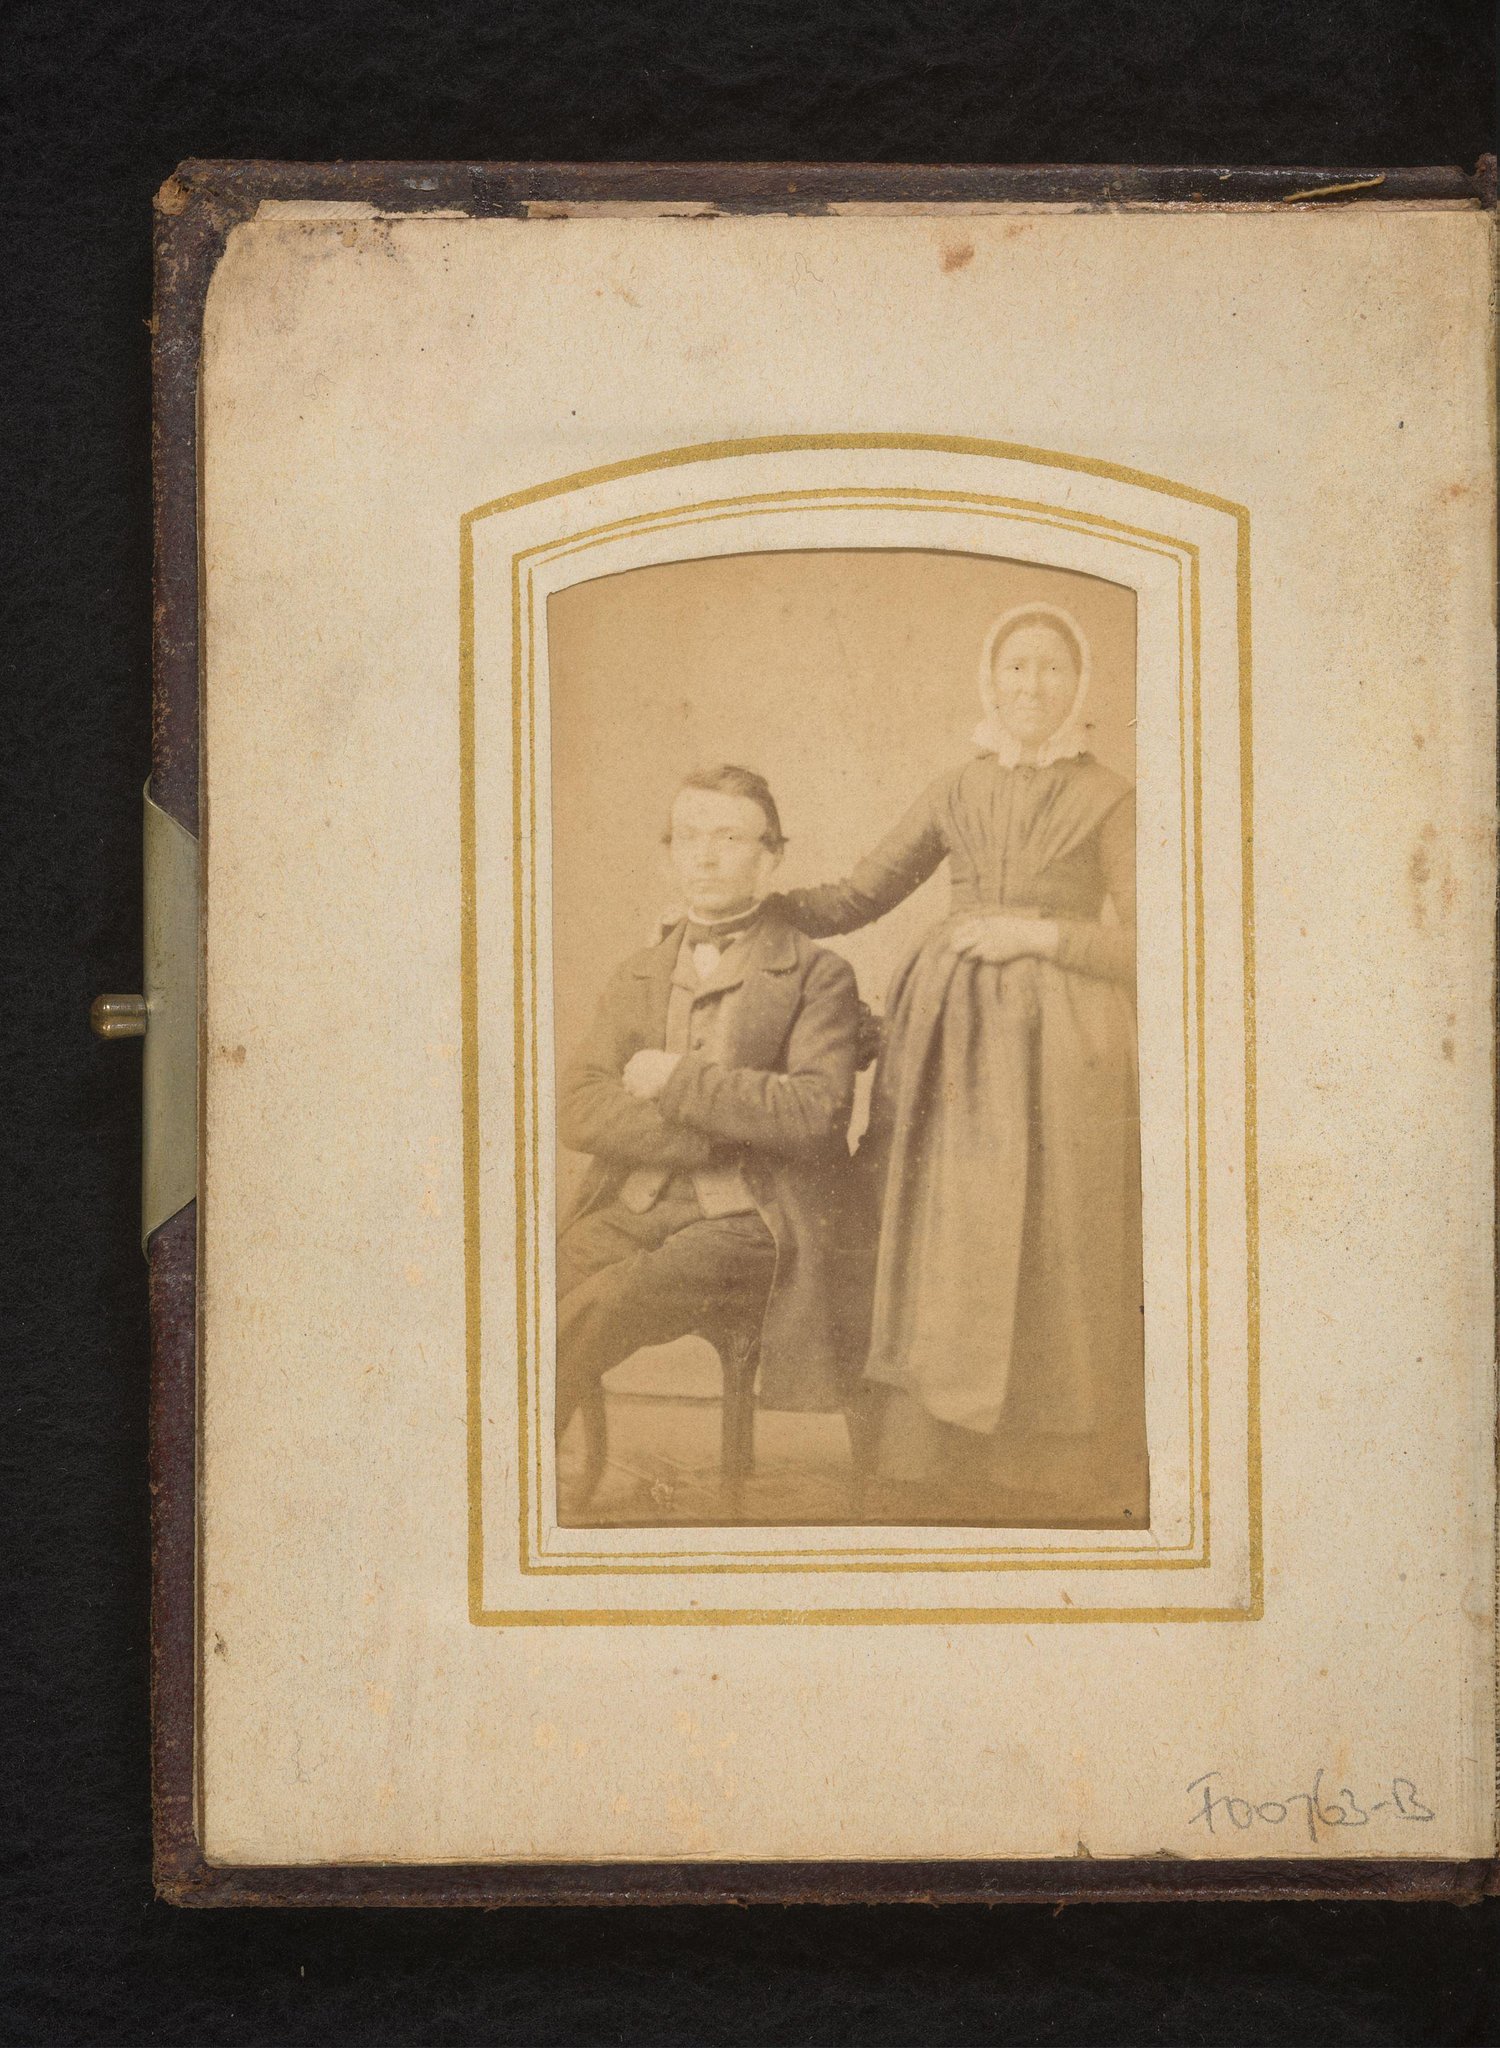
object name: album leaf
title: Portret van een zittende man en een staande vrouw met witte klederdrachtmuts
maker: mozes cohen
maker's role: fotograaf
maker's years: 1821-1899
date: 1860-1899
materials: cardboard, photographic support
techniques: albumen print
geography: zwolle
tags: sitting figure, historical persons - bb - woman, historical persons, head-gear: cap, folk costume, regional costume, standing figure - aa - female human figure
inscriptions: inscription: ‘M. Cohen/ Photographe/ DIEZERSTRAAT/ ZWOLLE/ Van deze Photographie/ kunnen steeds nabesteld worden.’